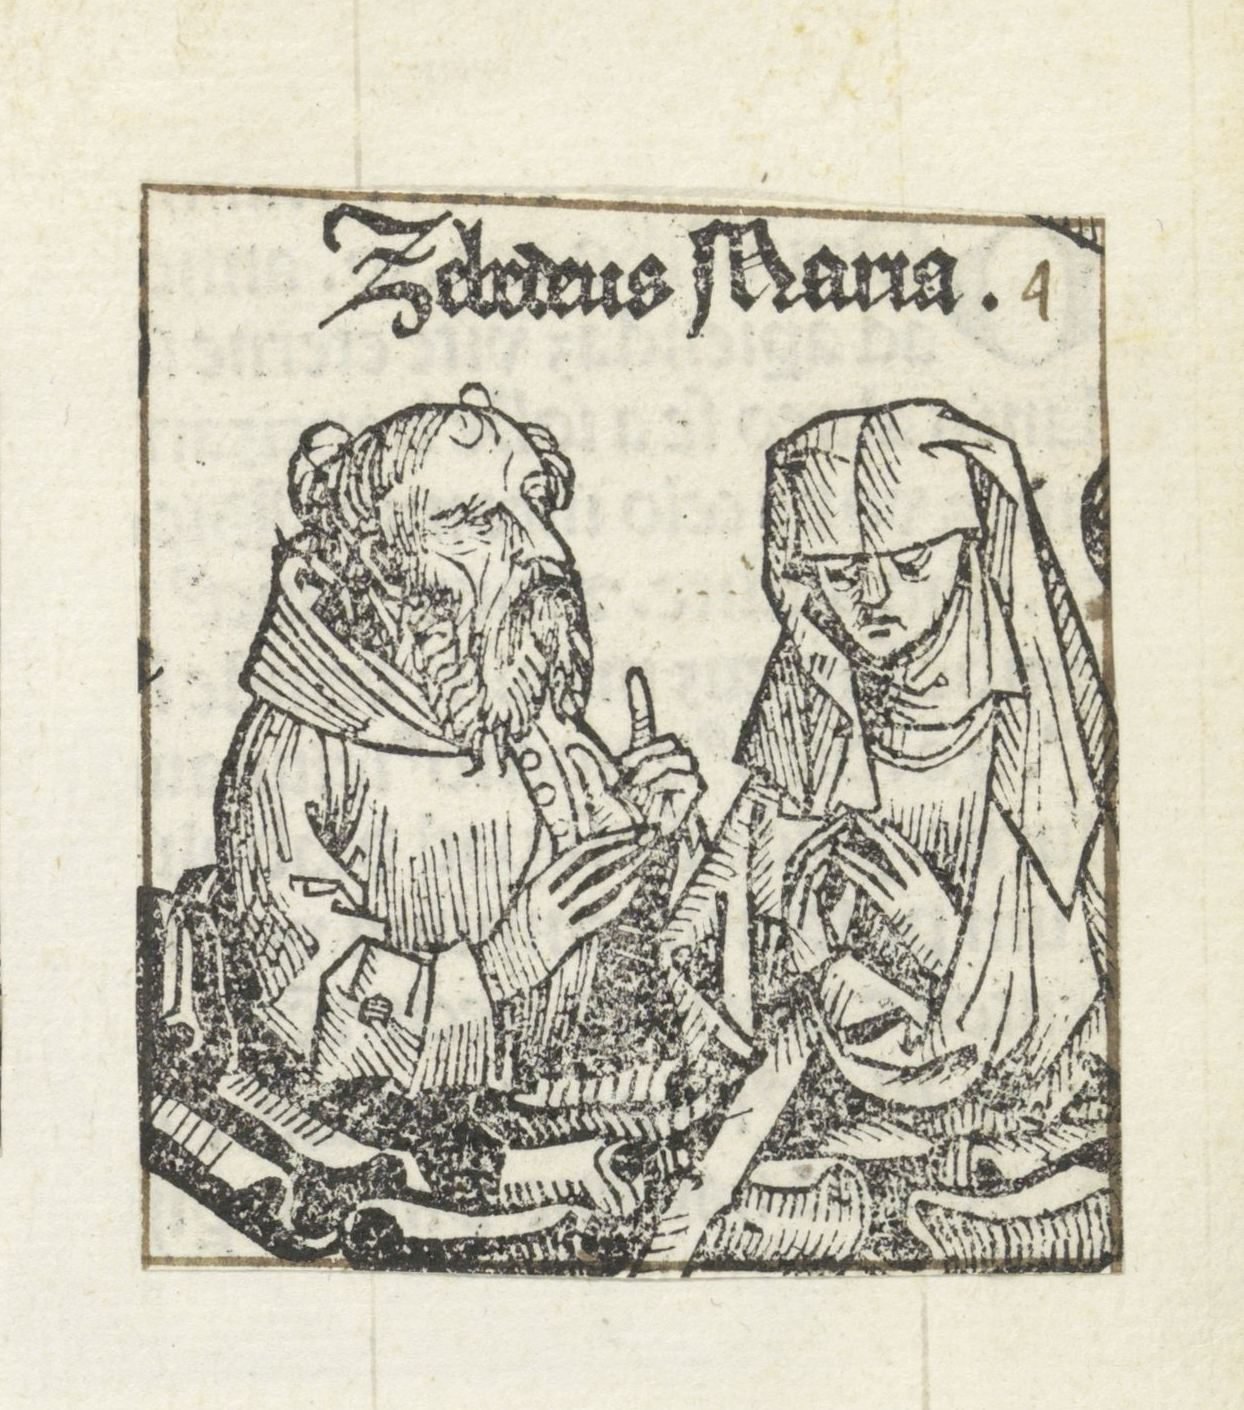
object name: album leaf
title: Maria Salome en Zebedeus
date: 1493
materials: paper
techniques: letterpress printing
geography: nuremberg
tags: prophets, sibyls, evangelists, doctors of the church; persons ~ the bible (not in biblical context)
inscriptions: inscription: ‘4’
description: Een bloemkelk met een man en vrouw. De vrouw heeft haar handen gevouwen. De voorstelling is onderdeel van de stamboom van Anna in de Liber Chronicarum. De tekst identificeert hen als Maria Salome en haar man Zebedeus. De prent maakt deel uit van een album.